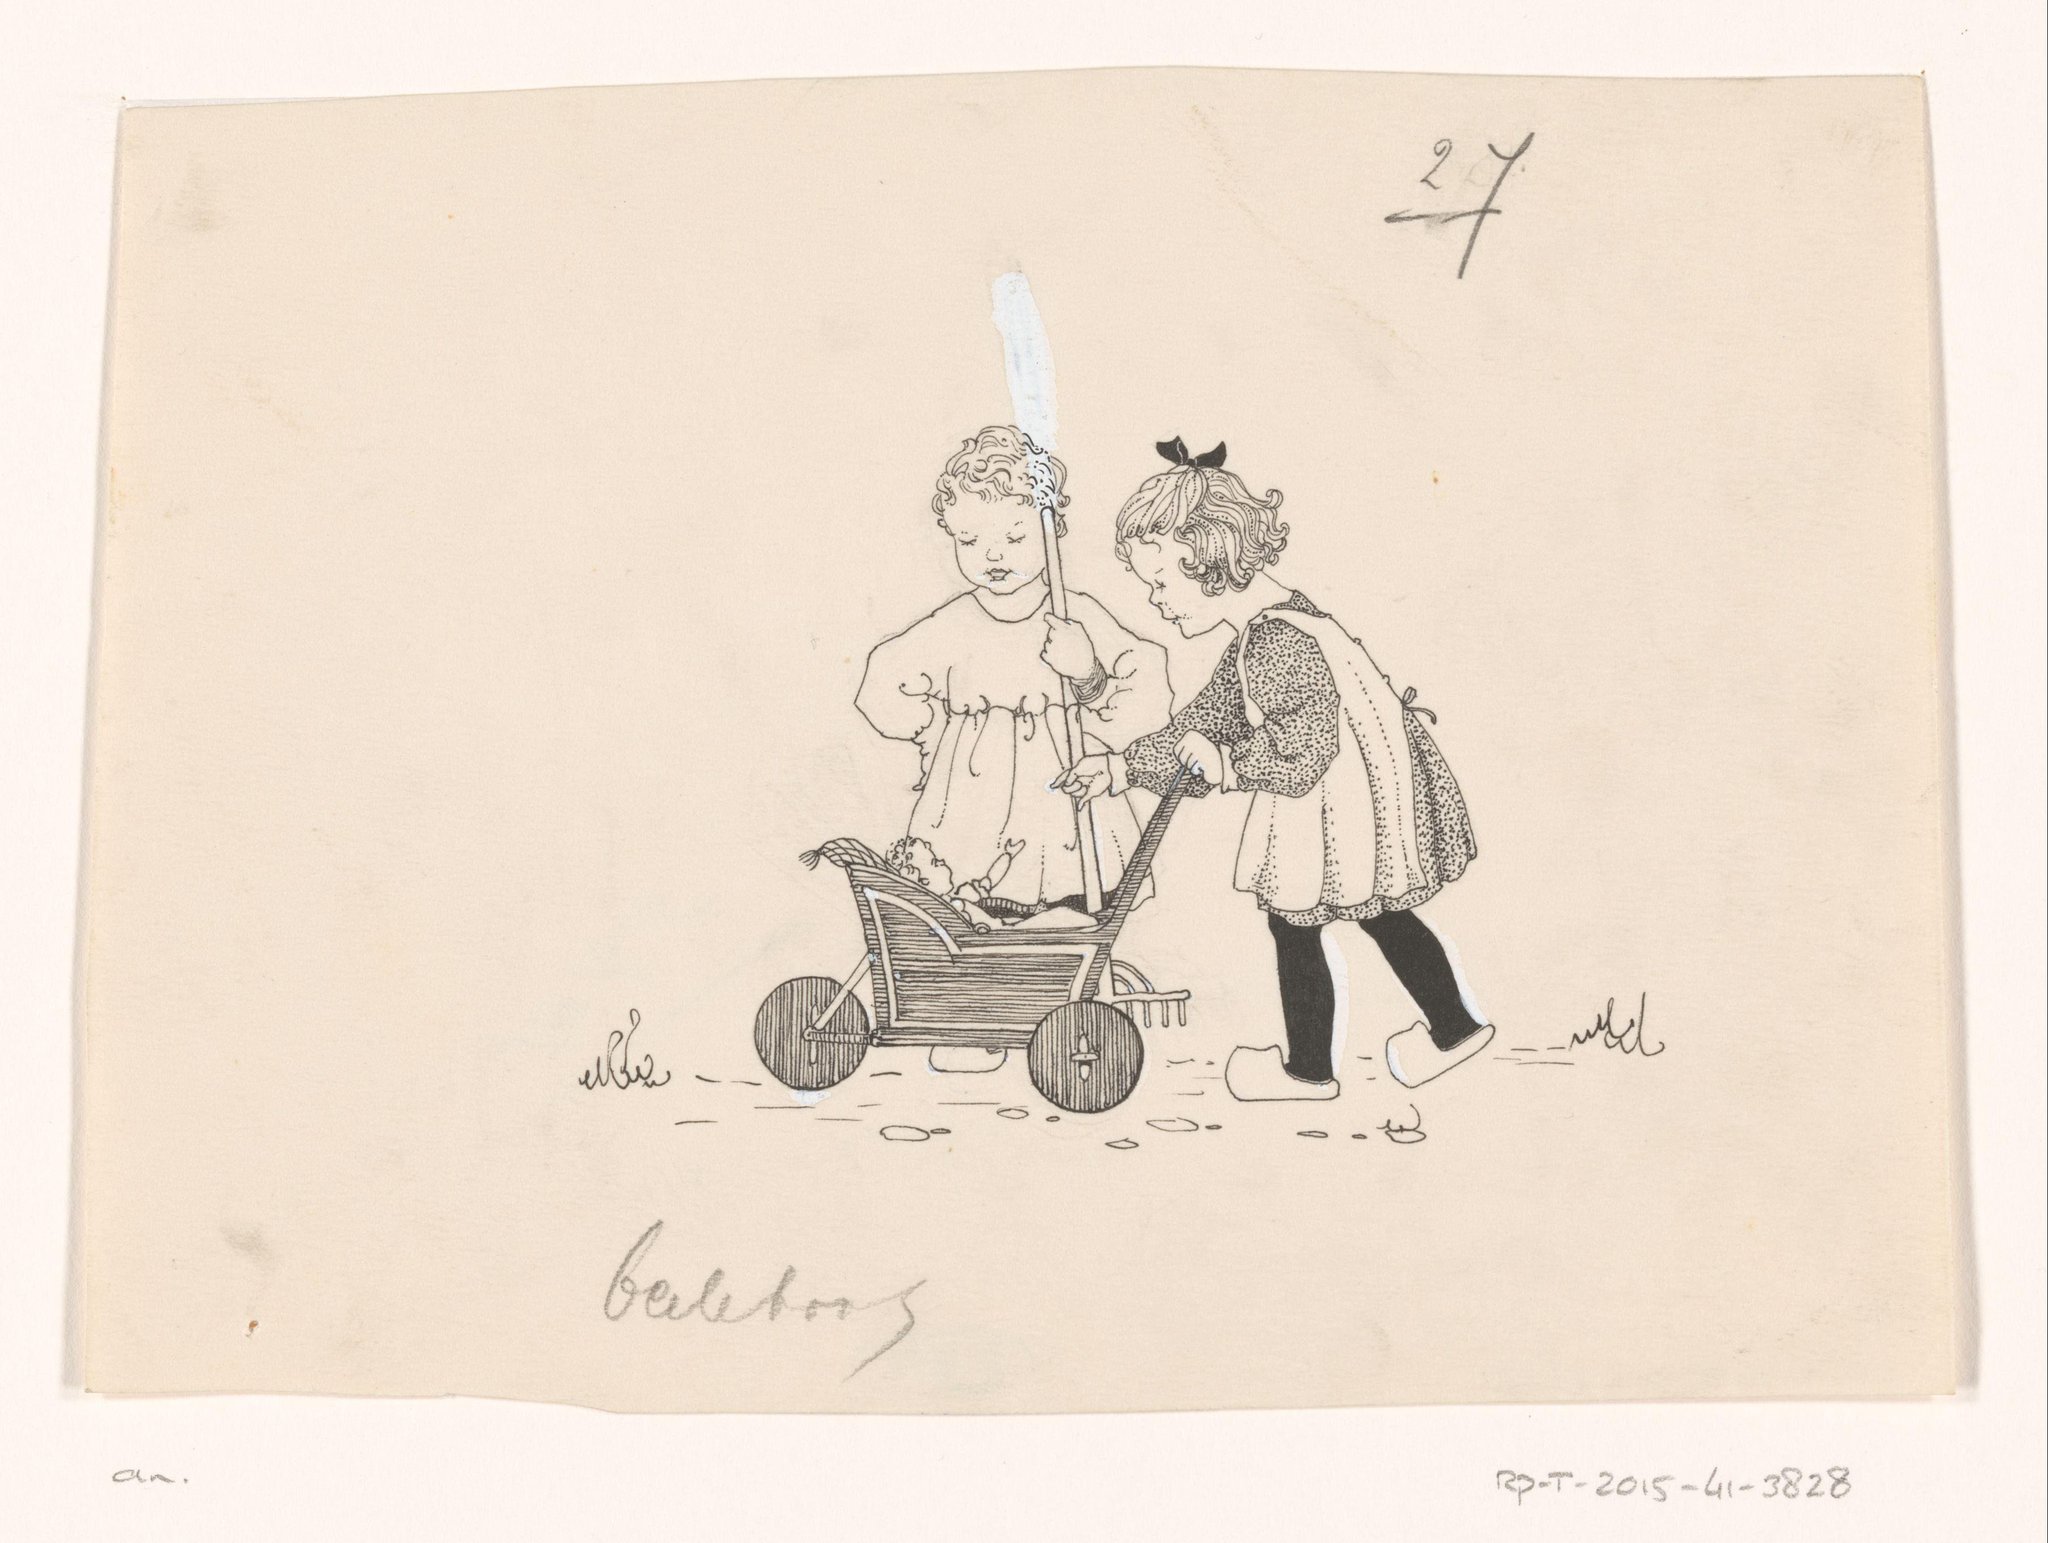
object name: boekillustratie ontwerp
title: Meisjes bij een poppenwagen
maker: Anonymous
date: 1890-1930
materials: paint, ink, paper, pencil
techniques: brush, pen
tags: (playing with) dolls, agricultural implements: rake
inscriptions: :, number: ‘27.’, collector's mark: Lugt 2228a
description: Een meisje staat achter een poppenwagen en wijst naar de pop. Een tweede meisje kijkt in de wagen. Ze houdt een hark in haar hand.